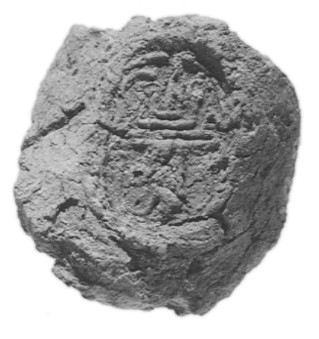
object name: sealing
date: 2030-1640 BCE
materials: clay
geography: egypt